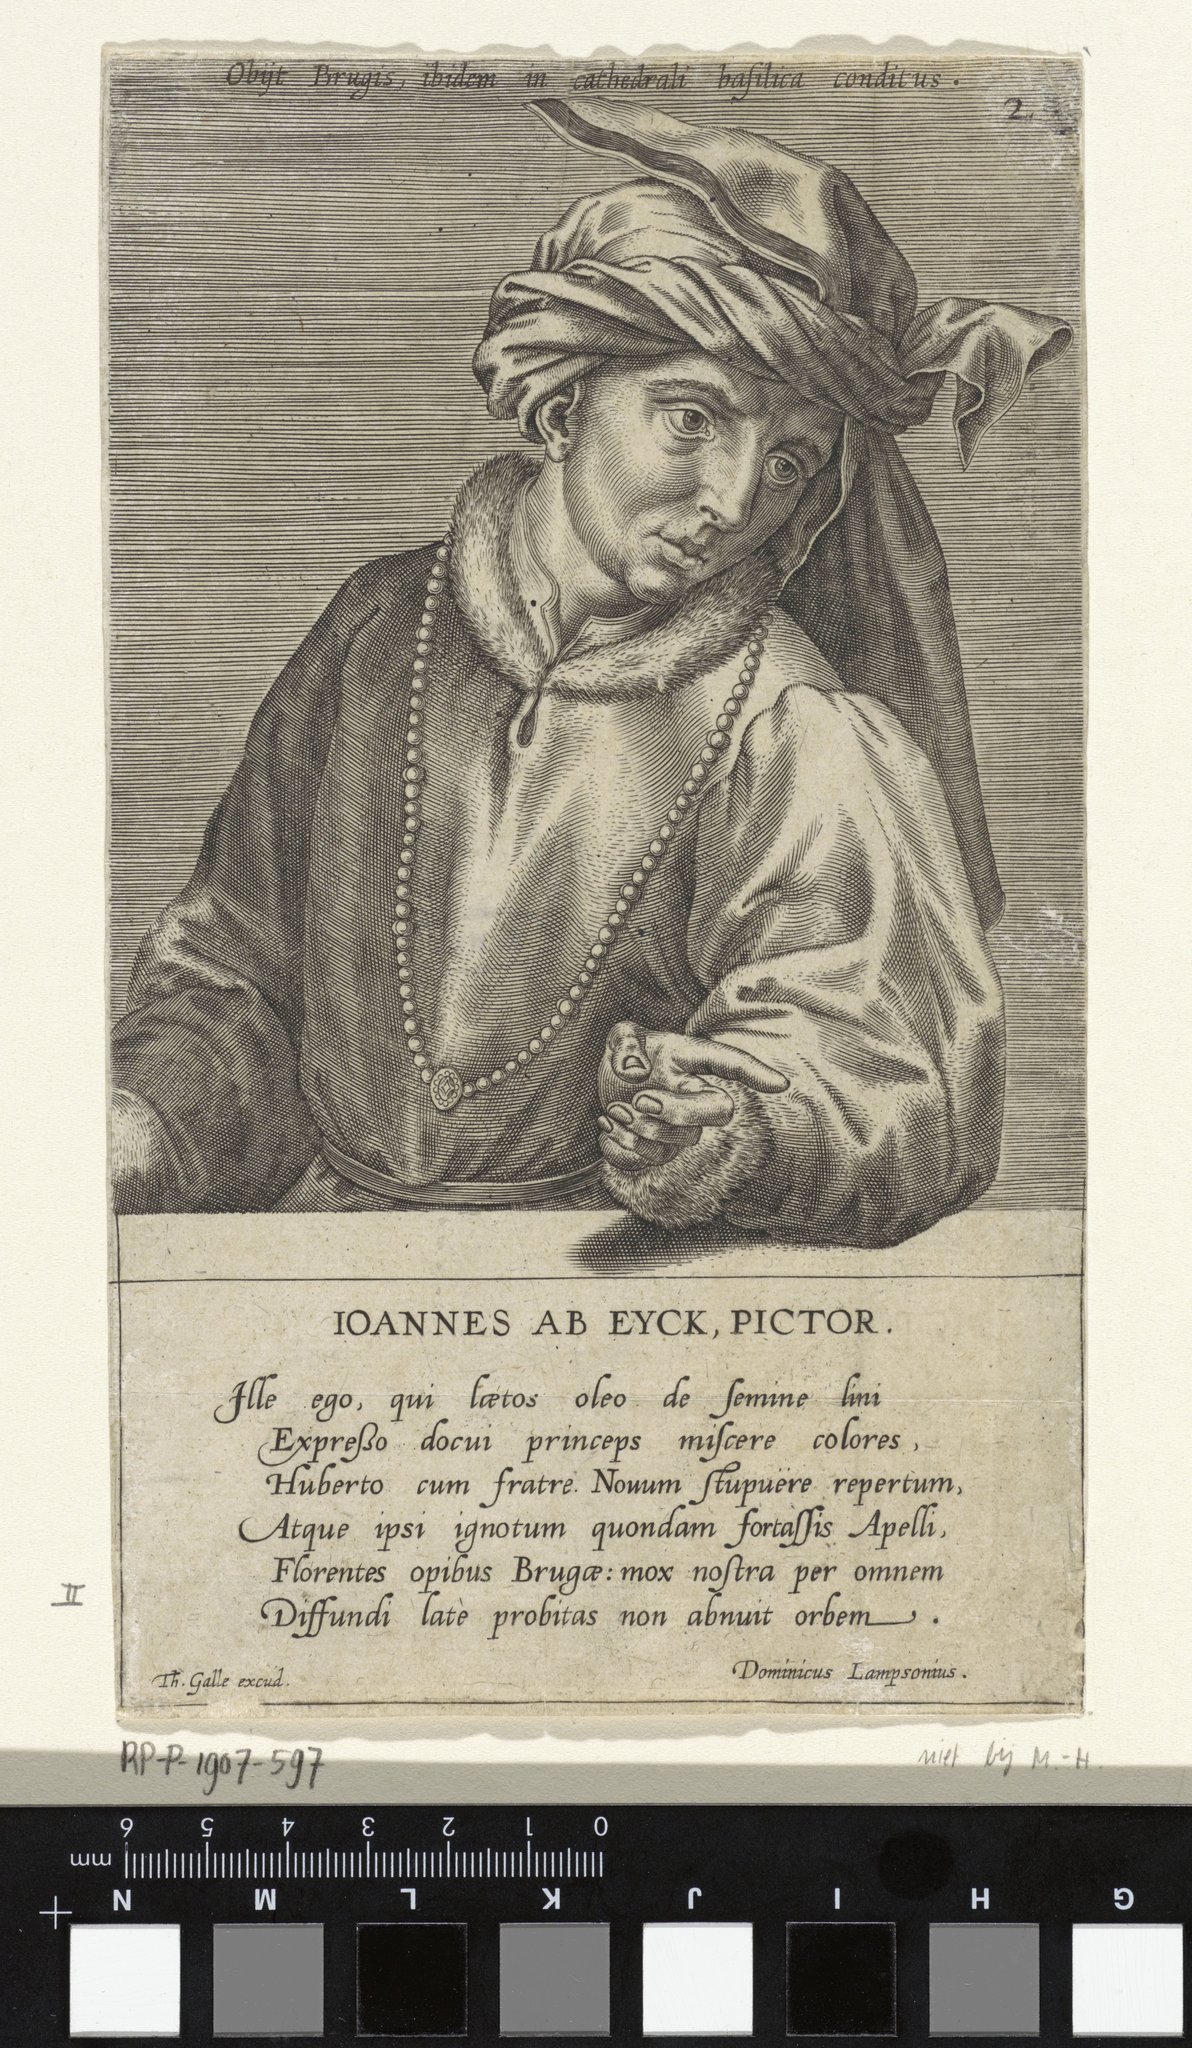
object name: print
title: Portretten van schilders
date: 1600-1650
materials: paper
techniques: engraving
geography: antwerp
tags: bruges, draughtsman, jan van eyck, portrait, self-portrait of painter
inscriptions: collector's mark: Lugt 2228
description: Boven de geportretteerde een regel met biografische gegevens in het Latijn. In de marge een zesregelig onderschrift in het Latijn.